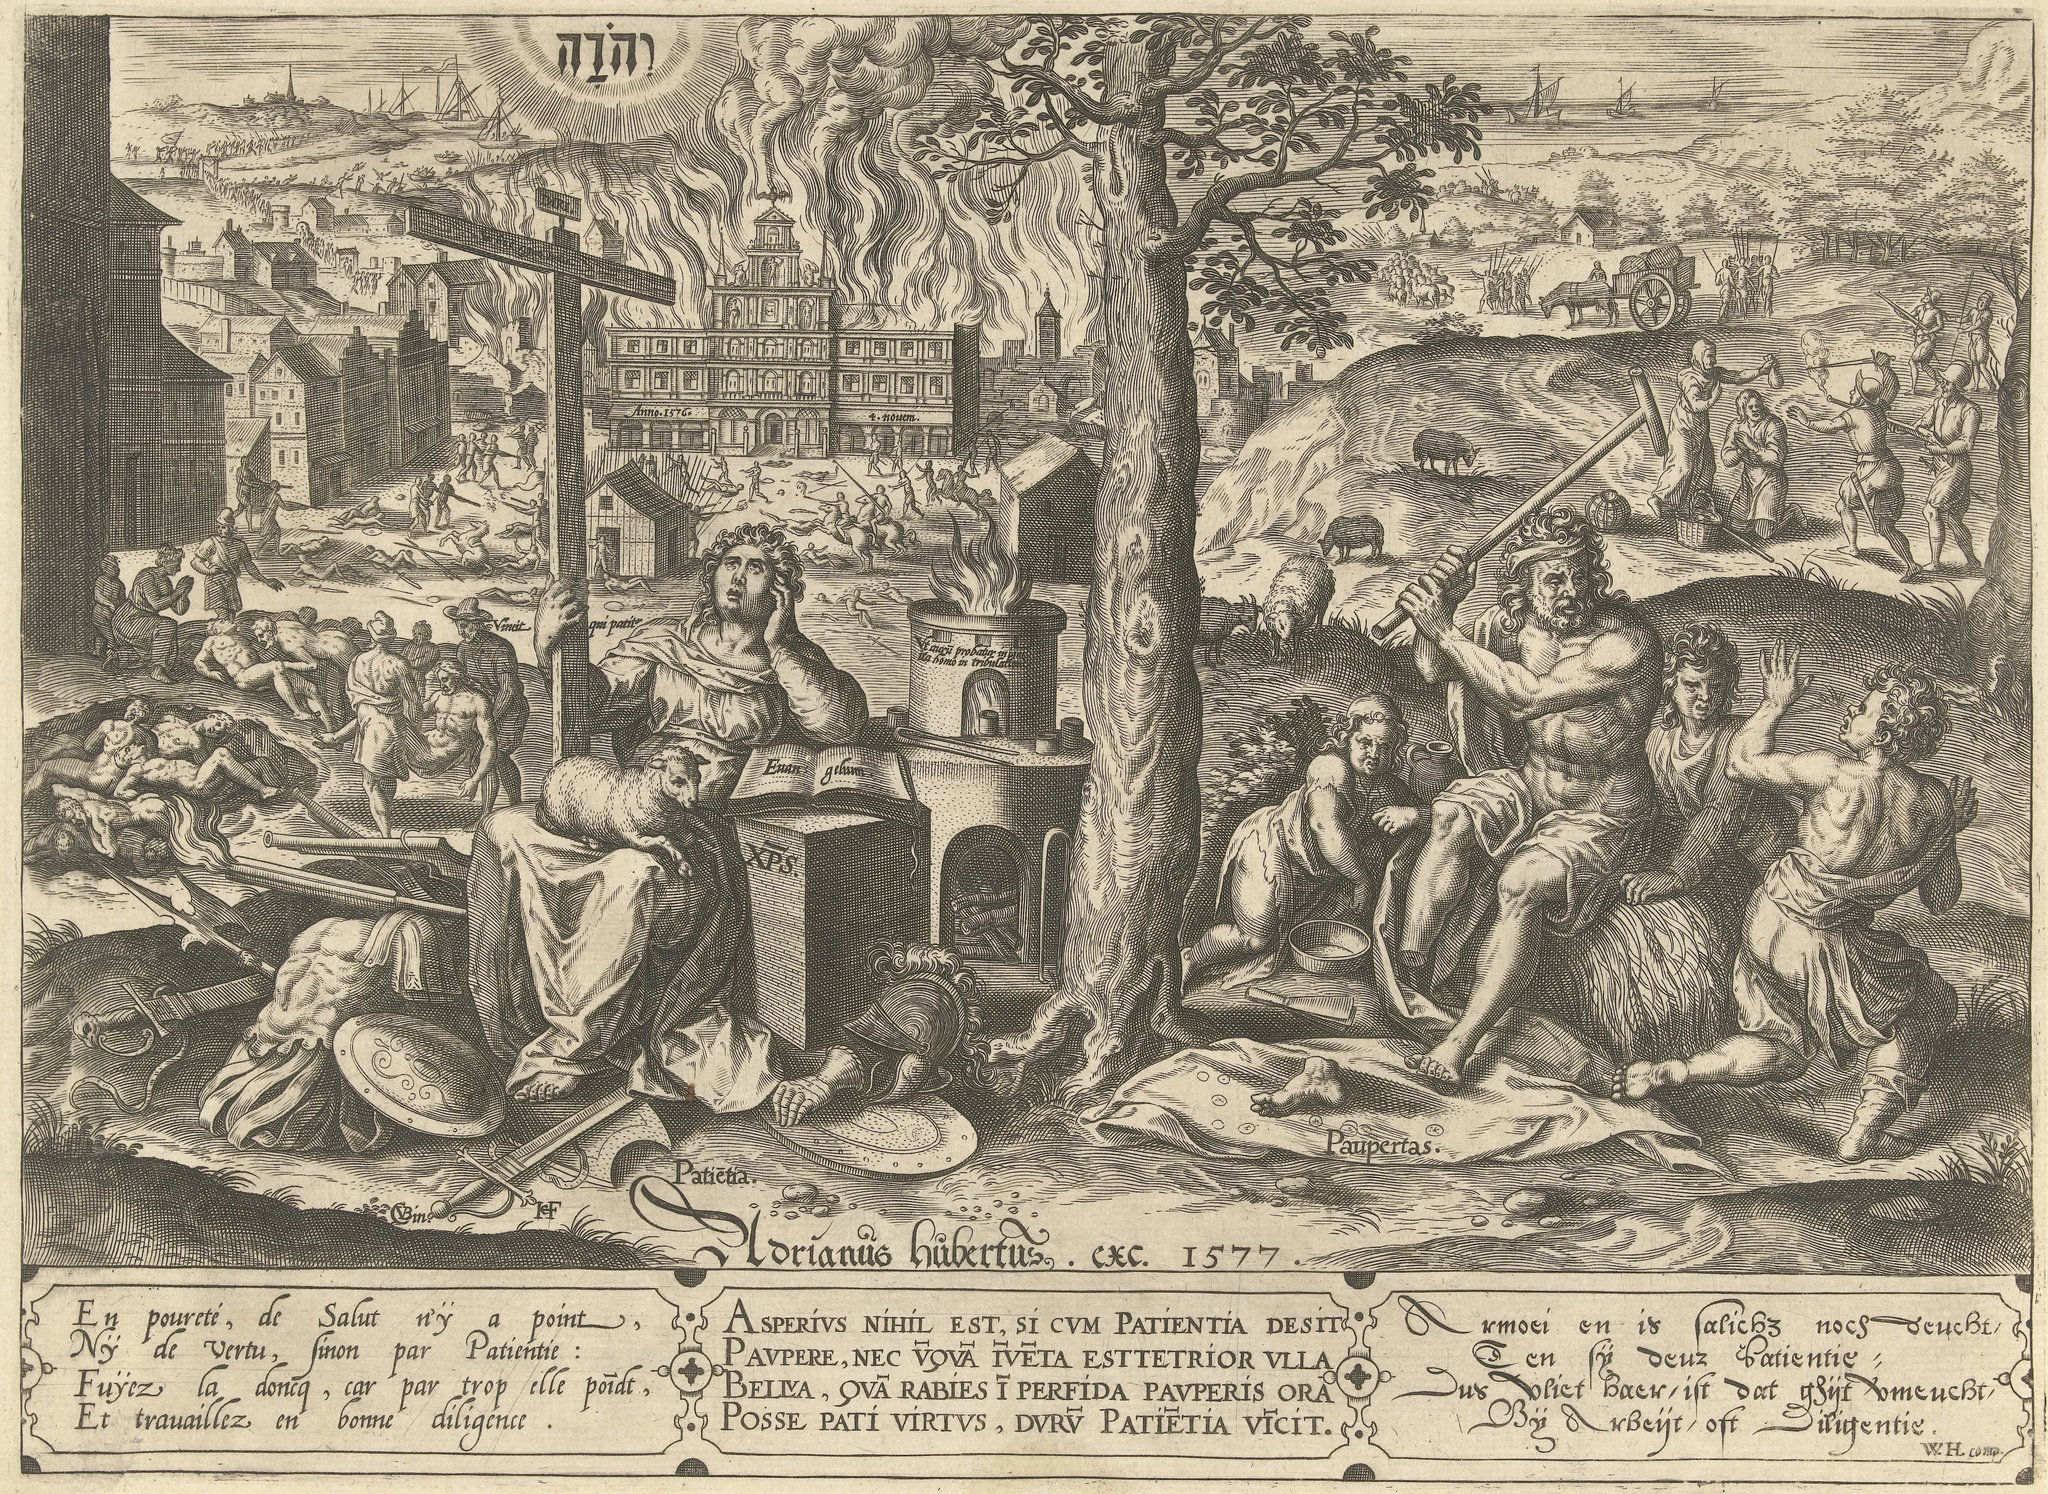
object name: print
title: Geduld in tegenspoed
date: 1577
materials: paper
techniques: engraving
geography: antwerp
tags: lamb bearing cross or banner, 'agnus dei' ~ symbol of christ, patience; 'patienza' (ripa), the cross ~ symbols of christ, disabilities, deformations, weapons, fire, oven, furnace ~ interior of industrial structure, poverty; 'povertà', 'povertà del doni', 'povertà in uno ch'habbia bell'ingegno' (ripa), plundering ~ soldiers, tetragram (in roman or hebrew script) ~ symbol of god the father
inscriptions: collector's mark: Lugt 2228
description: Op de voorgrond links de personificatie Geduld (Patientia), omringd door wapentuig. Ze houdt het kruis vast en het Lam Gods zit op haar schoot. Naast haar ligt een bijbel. Ze heeft haar ogen ten hemel gericht, naar het tetragram van God. Rechts op de voorgrond Armoede (Paupertas). Hij mist een voet en is gekleed als bedelaar en jaagt kwajongens weg met zijn staf. Op de achtergrond de verschrikkingen van de Tachtigjarige Oorlog. Links de Spaanse Furie van 1576, toen Antwerpen door Spaanse soldaten werd geplunderd en het stadhuis in brand werd gestoken. Rechts de roofovervallen van Spaanse troepen op het Brabantse platteland. De afbeelding kan geïnterpreteerd worden als een verzoek standvastig in het (protestants) geloof te zijn en geduldig de tijd af te wachten, ondanks de tegenslagen en de armoede die de oorlog teweegbrengt. De prent heeft een onderschrift in Nederlands, Latijn en Frans in verzen. De verzen veroordelen armoede en sporen aan tot vlijt en arbeid. Wel wordt een uitzondering gemaakt voor armoede ten tijde van oorlog.